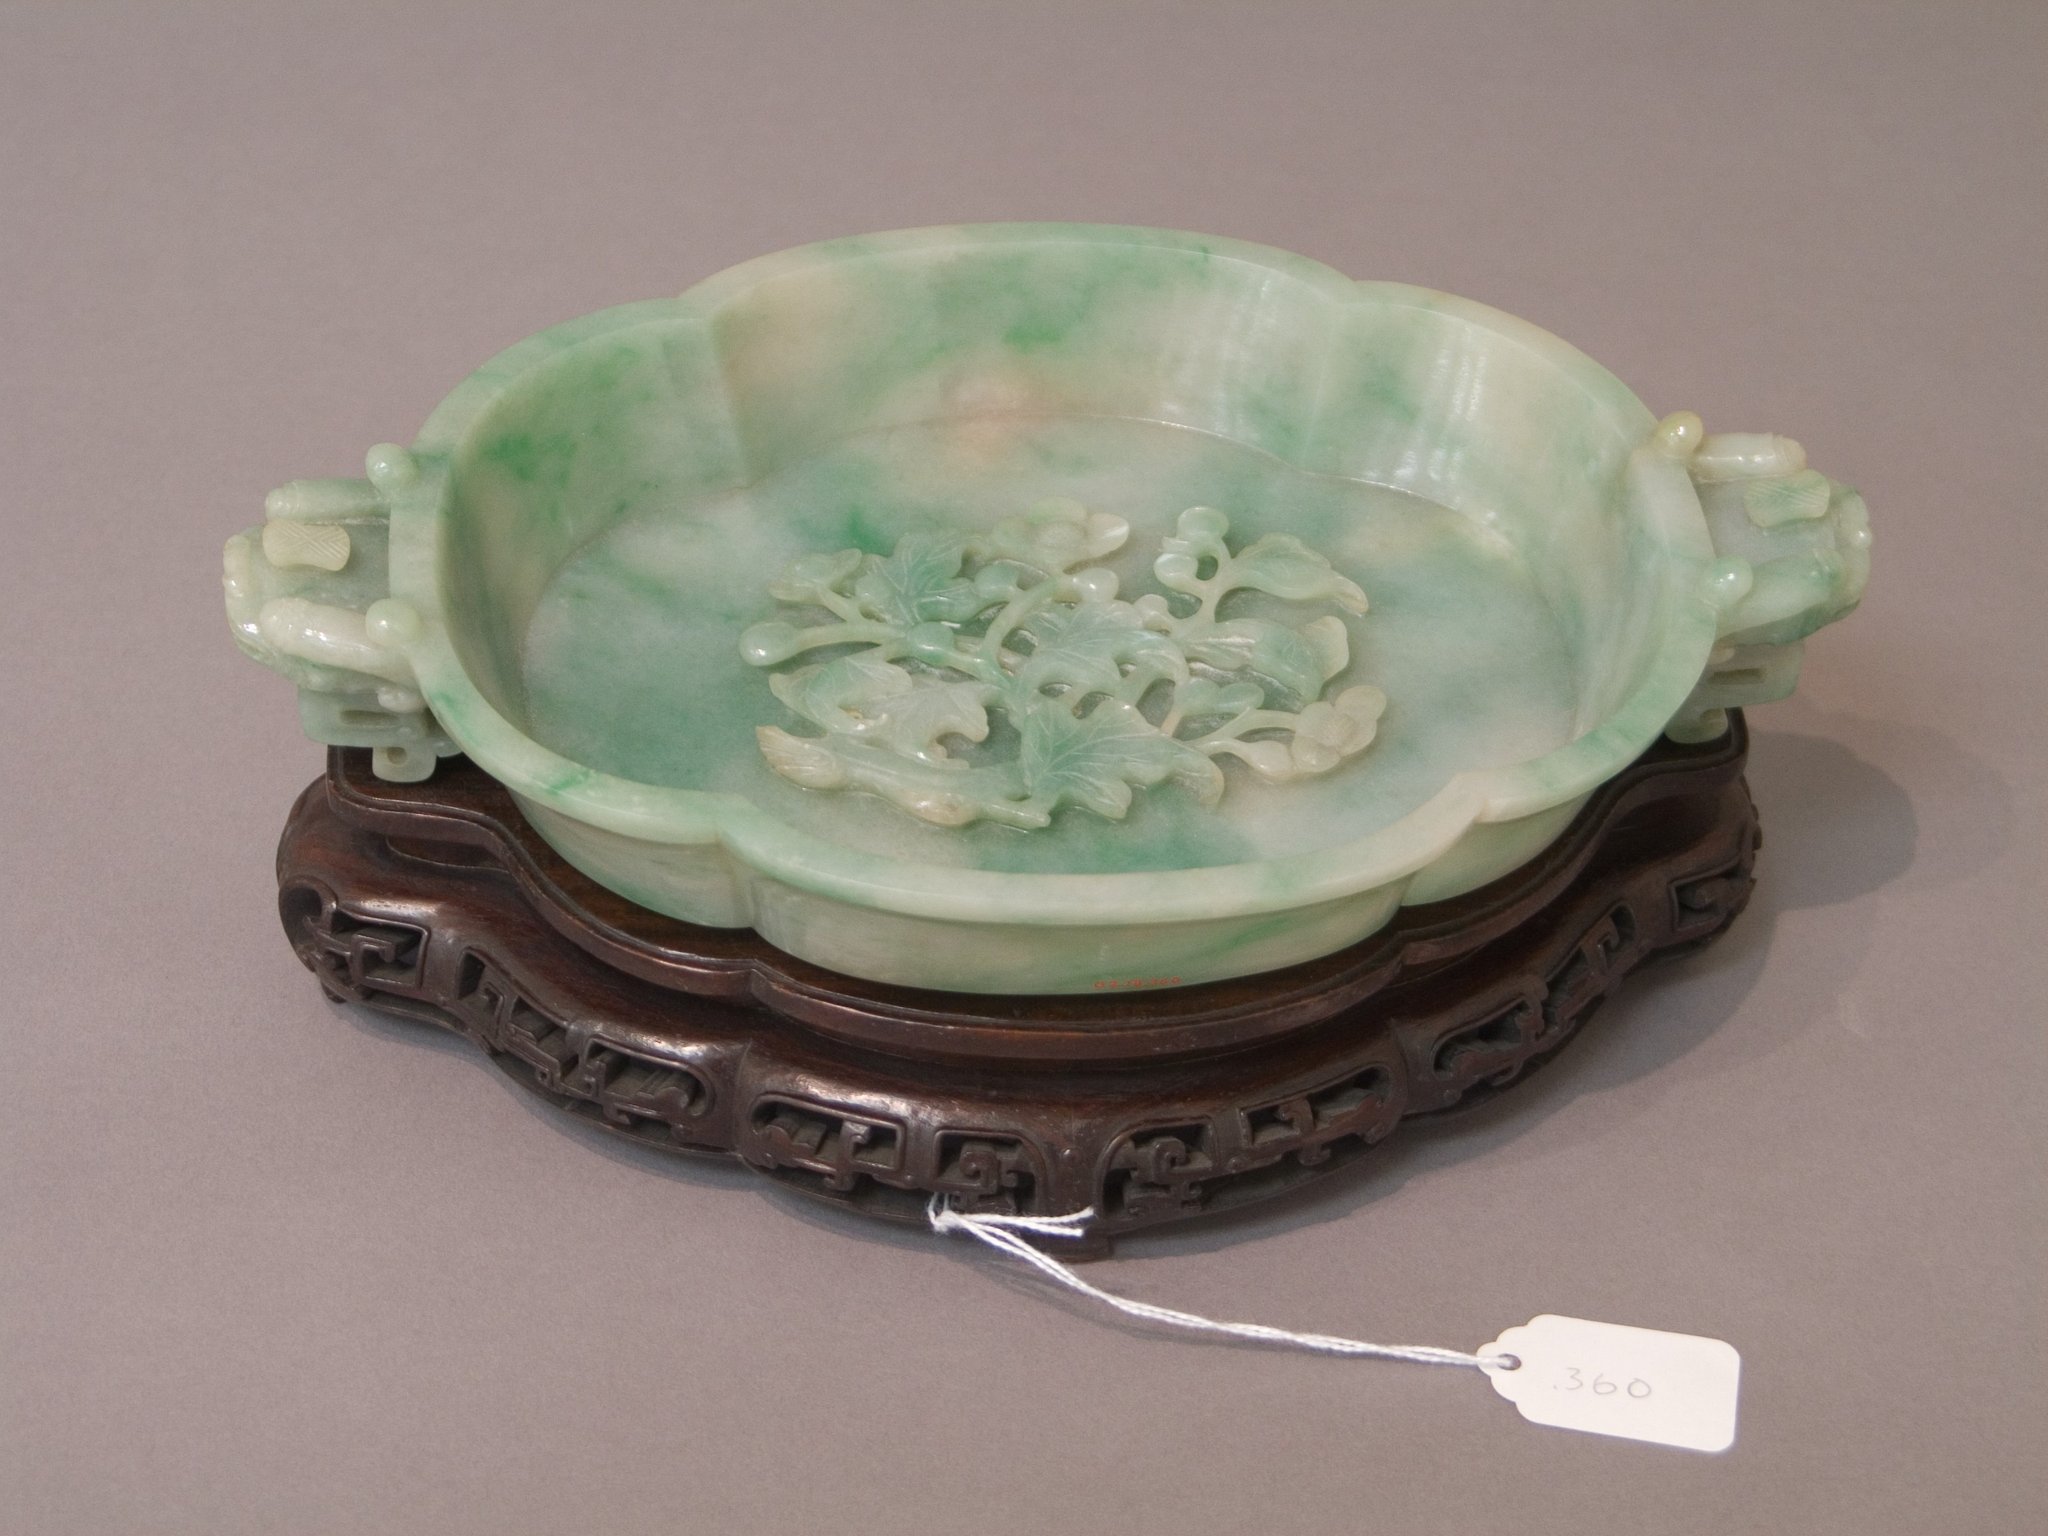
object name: dish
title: Oval Dish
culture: chinese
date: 1368-1644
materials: jade